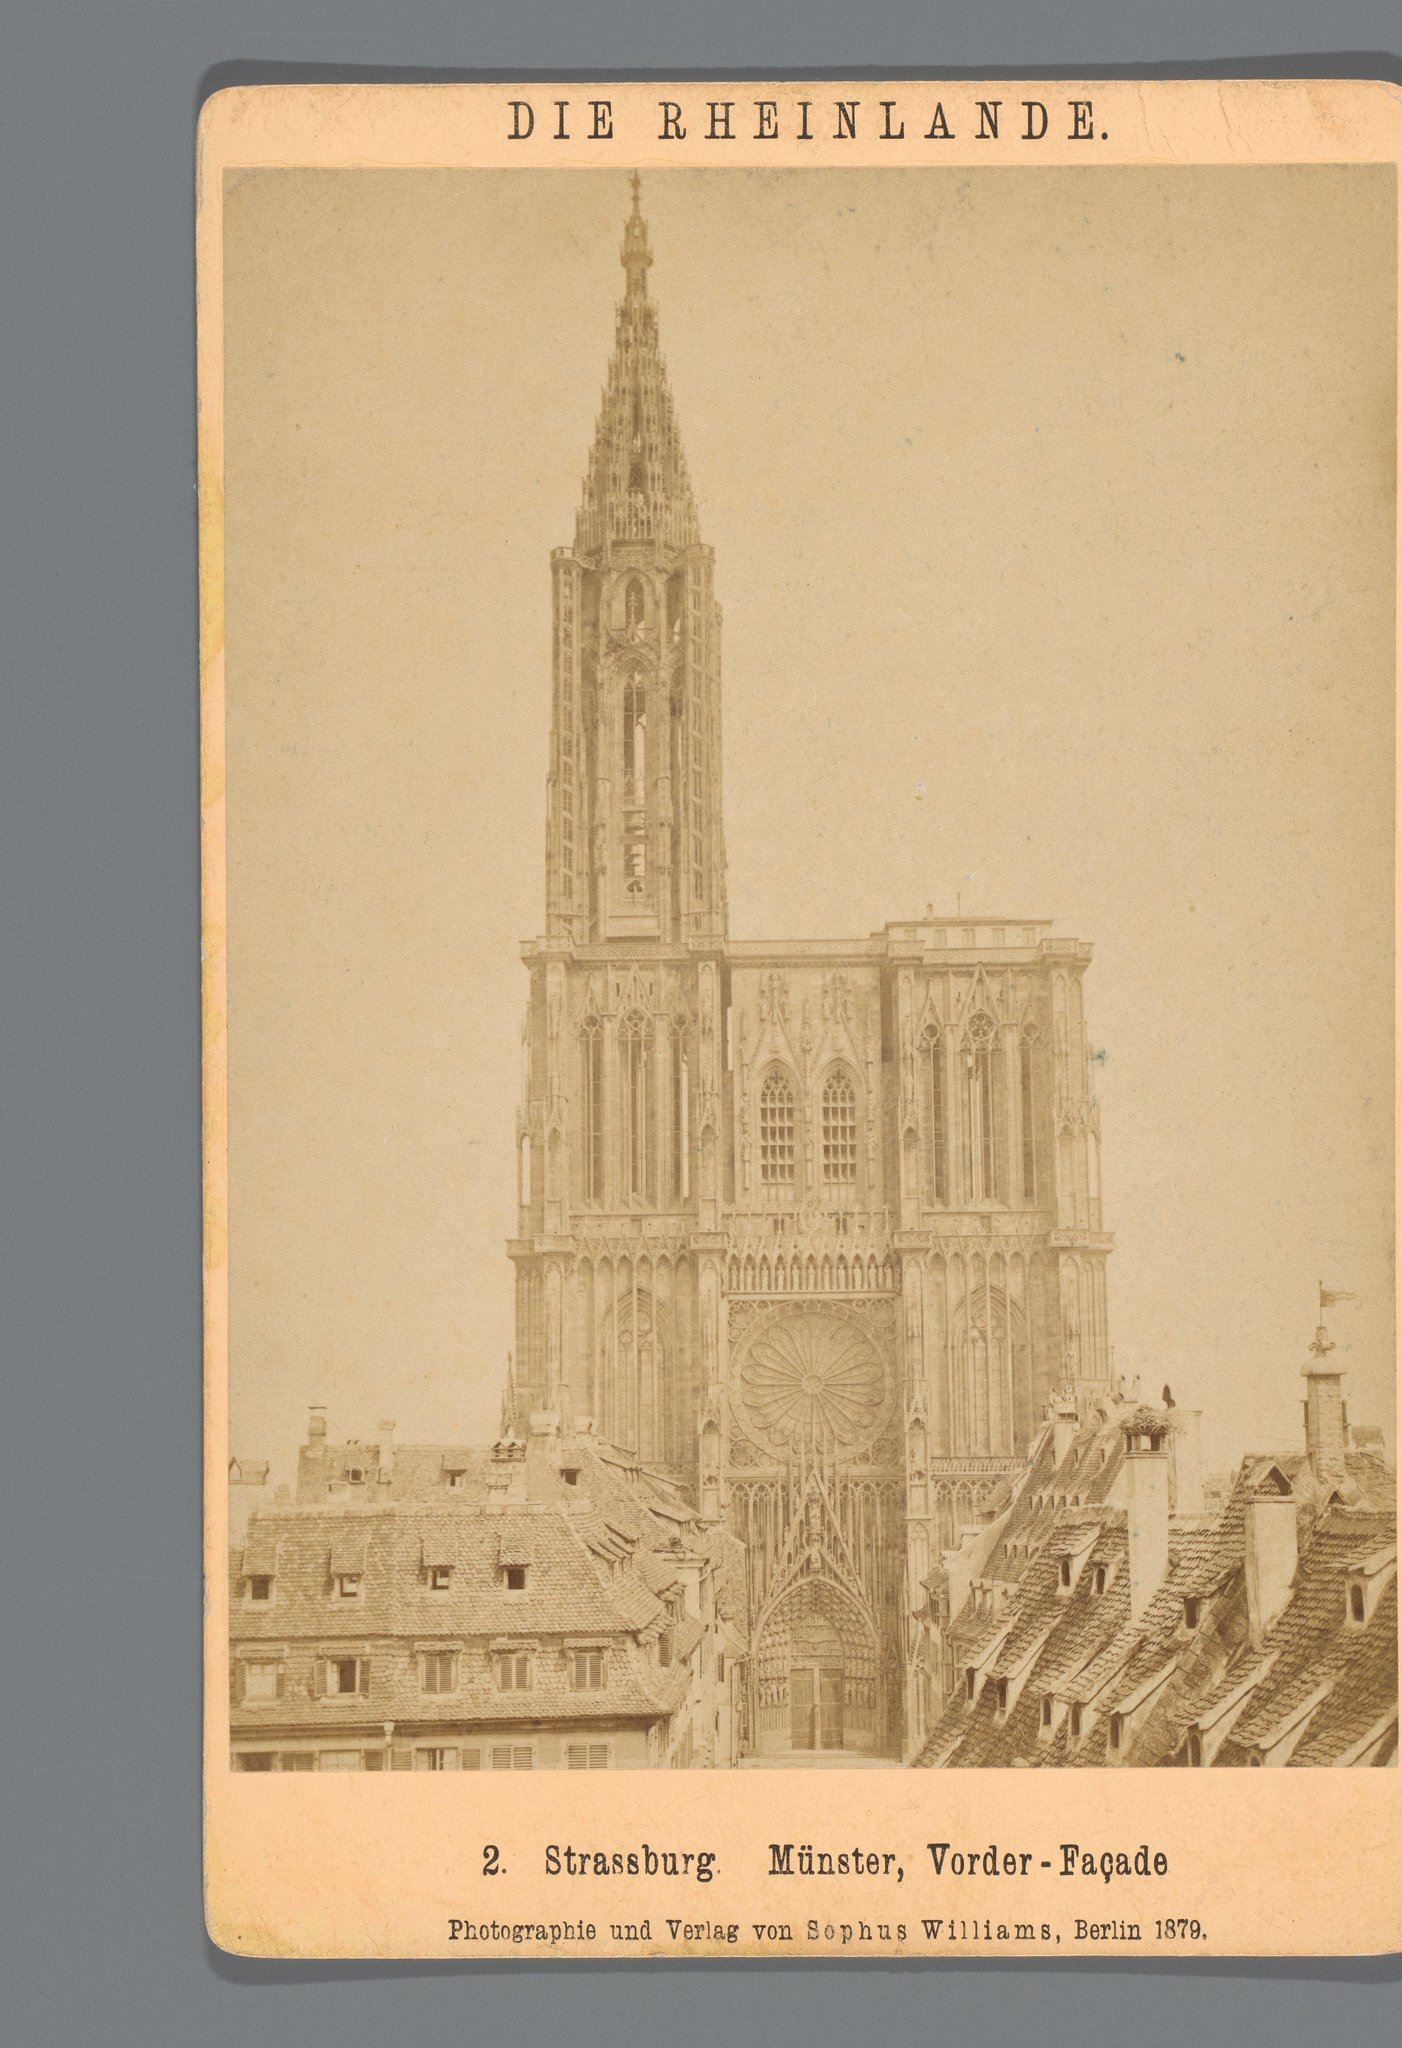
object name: photograph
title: Strassburg. Münster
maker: Anonymous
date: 1879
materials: photographic support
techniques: albumen print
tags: münster, straatsburg (frankrijk)